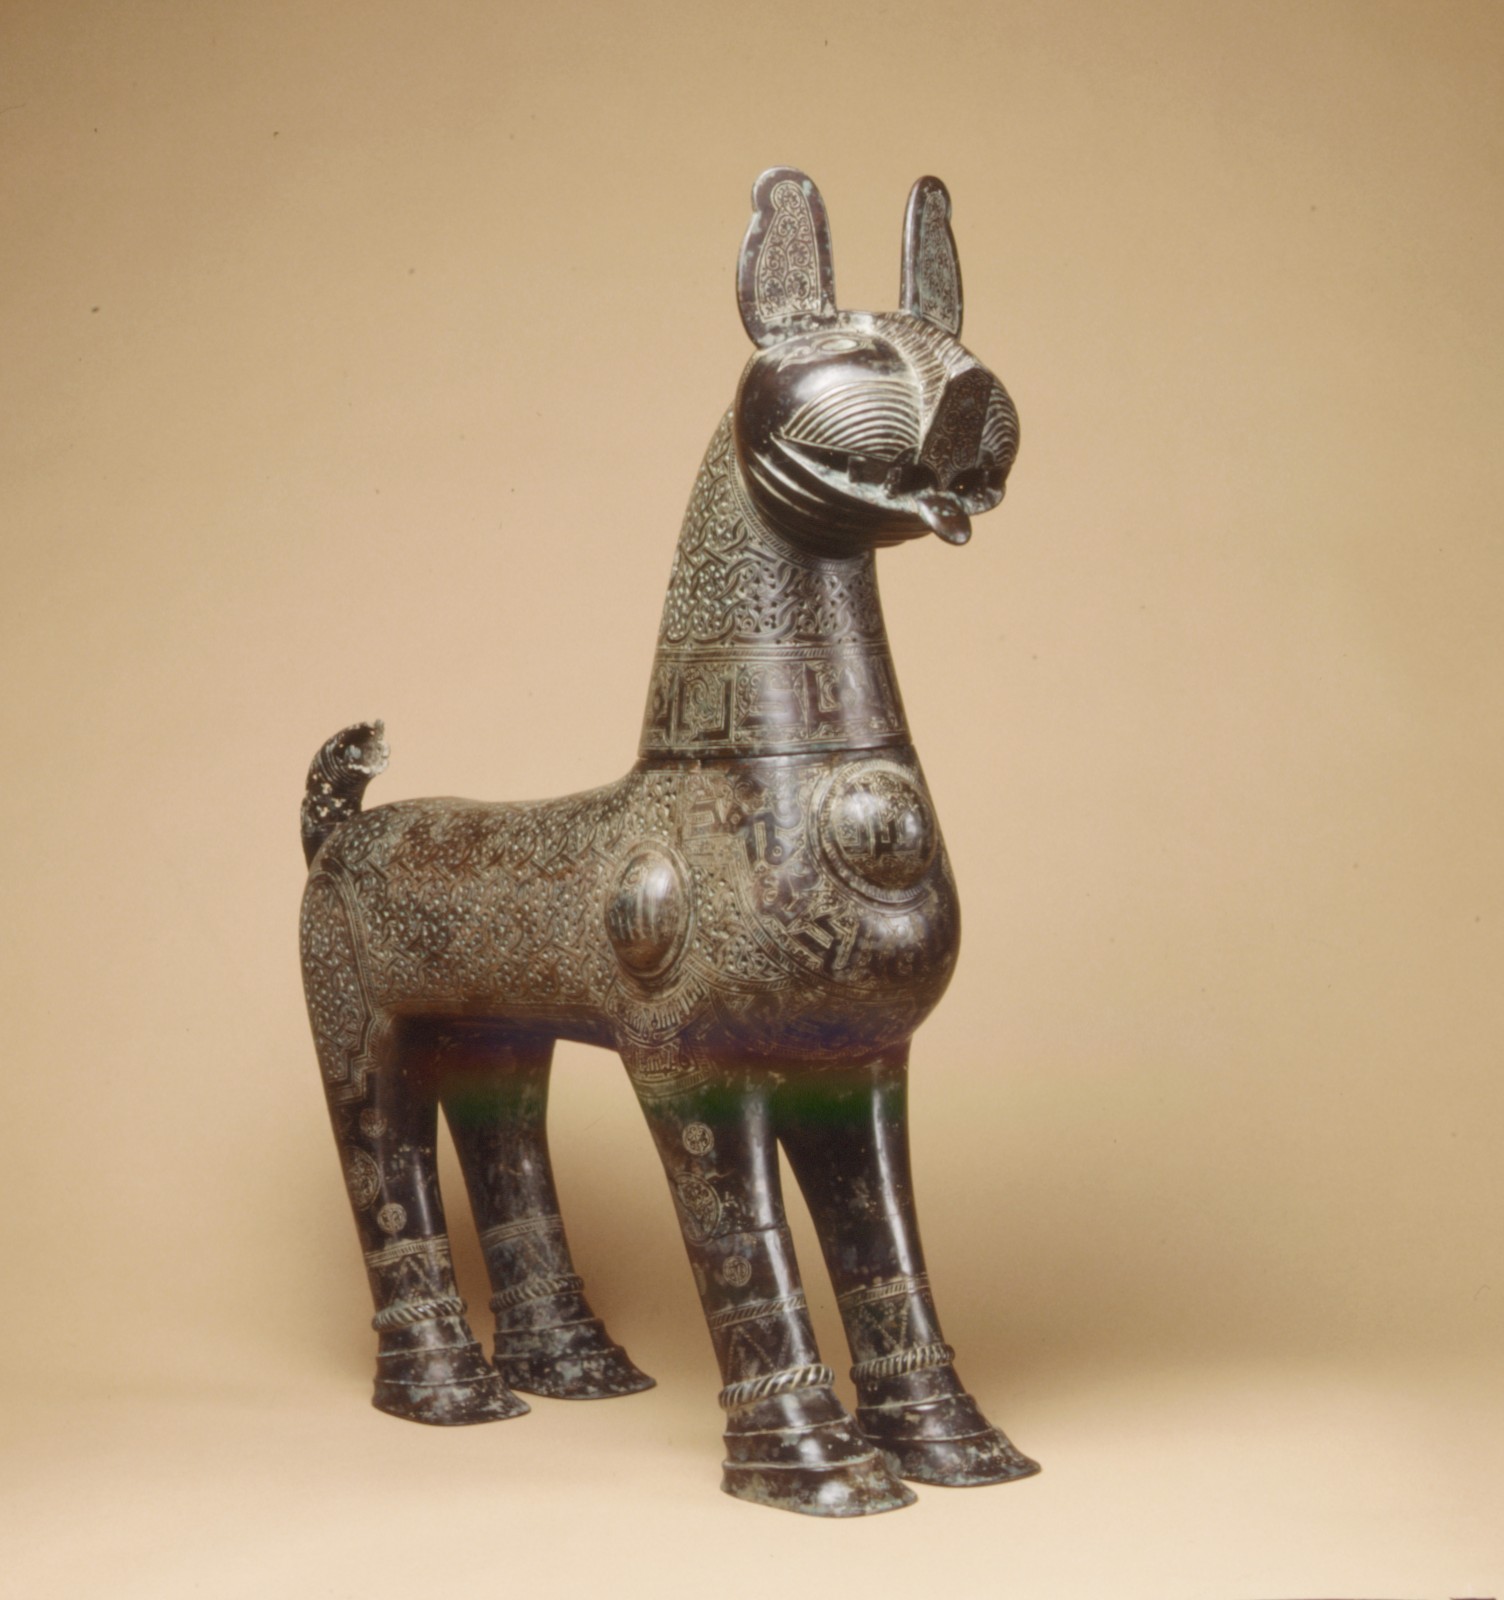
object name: incense burner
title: Incense Burner of Amir Saif al-Dunya wa’l-Din ibn Muhammad al-Mawardi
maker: ja`far ibn muhammad ibn `ali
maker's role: maker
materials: bronze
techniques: casting, chasing, engraving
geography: iran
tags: animals